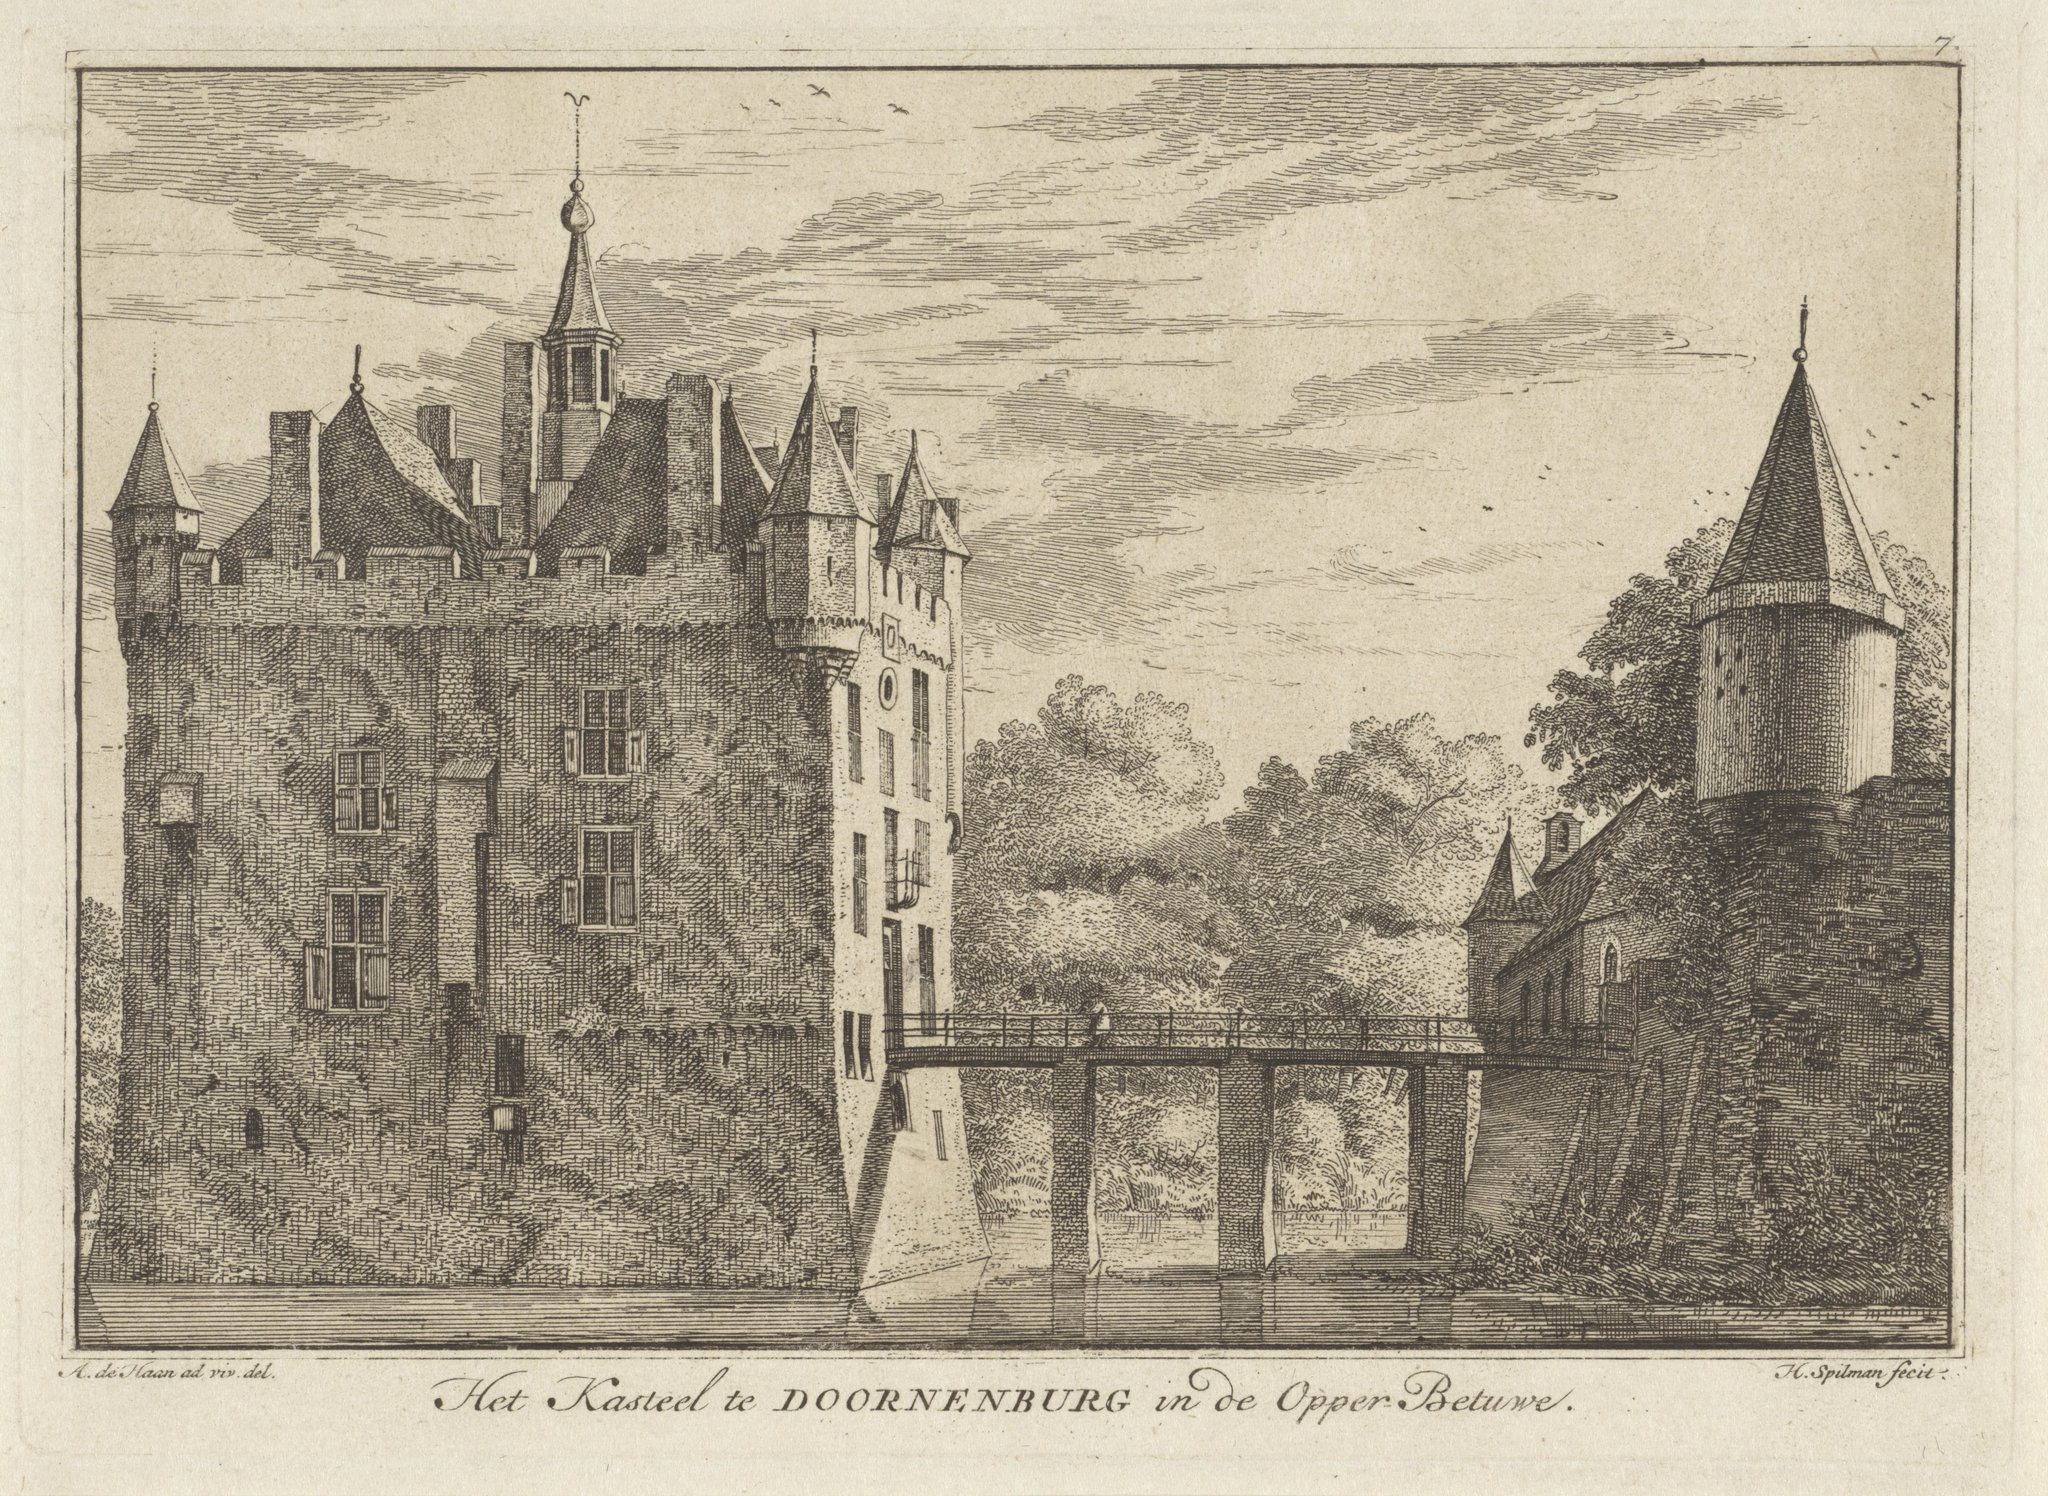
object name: print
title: Het kasteel te Doornenburg in de Opper Betuwe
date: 1738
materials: paper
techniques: etching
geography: haarlem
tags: castle